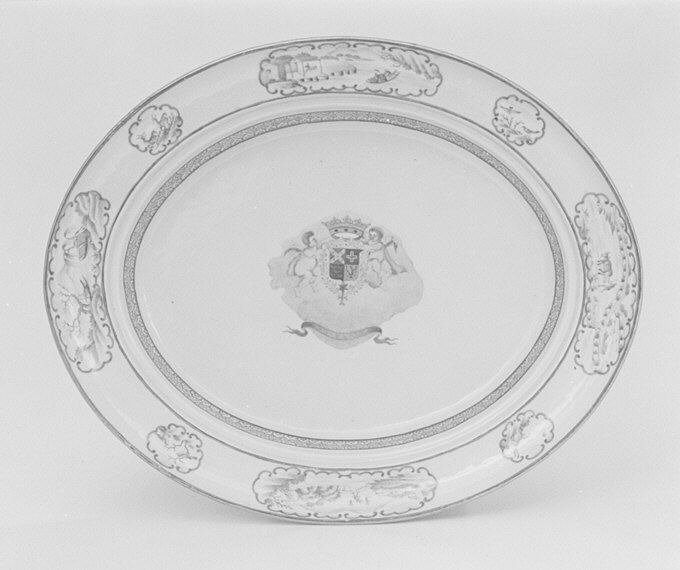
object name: platter and rack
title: Platter with rack (part of a service)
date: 1800-1805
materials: hard paste porcelain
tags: coat of arms